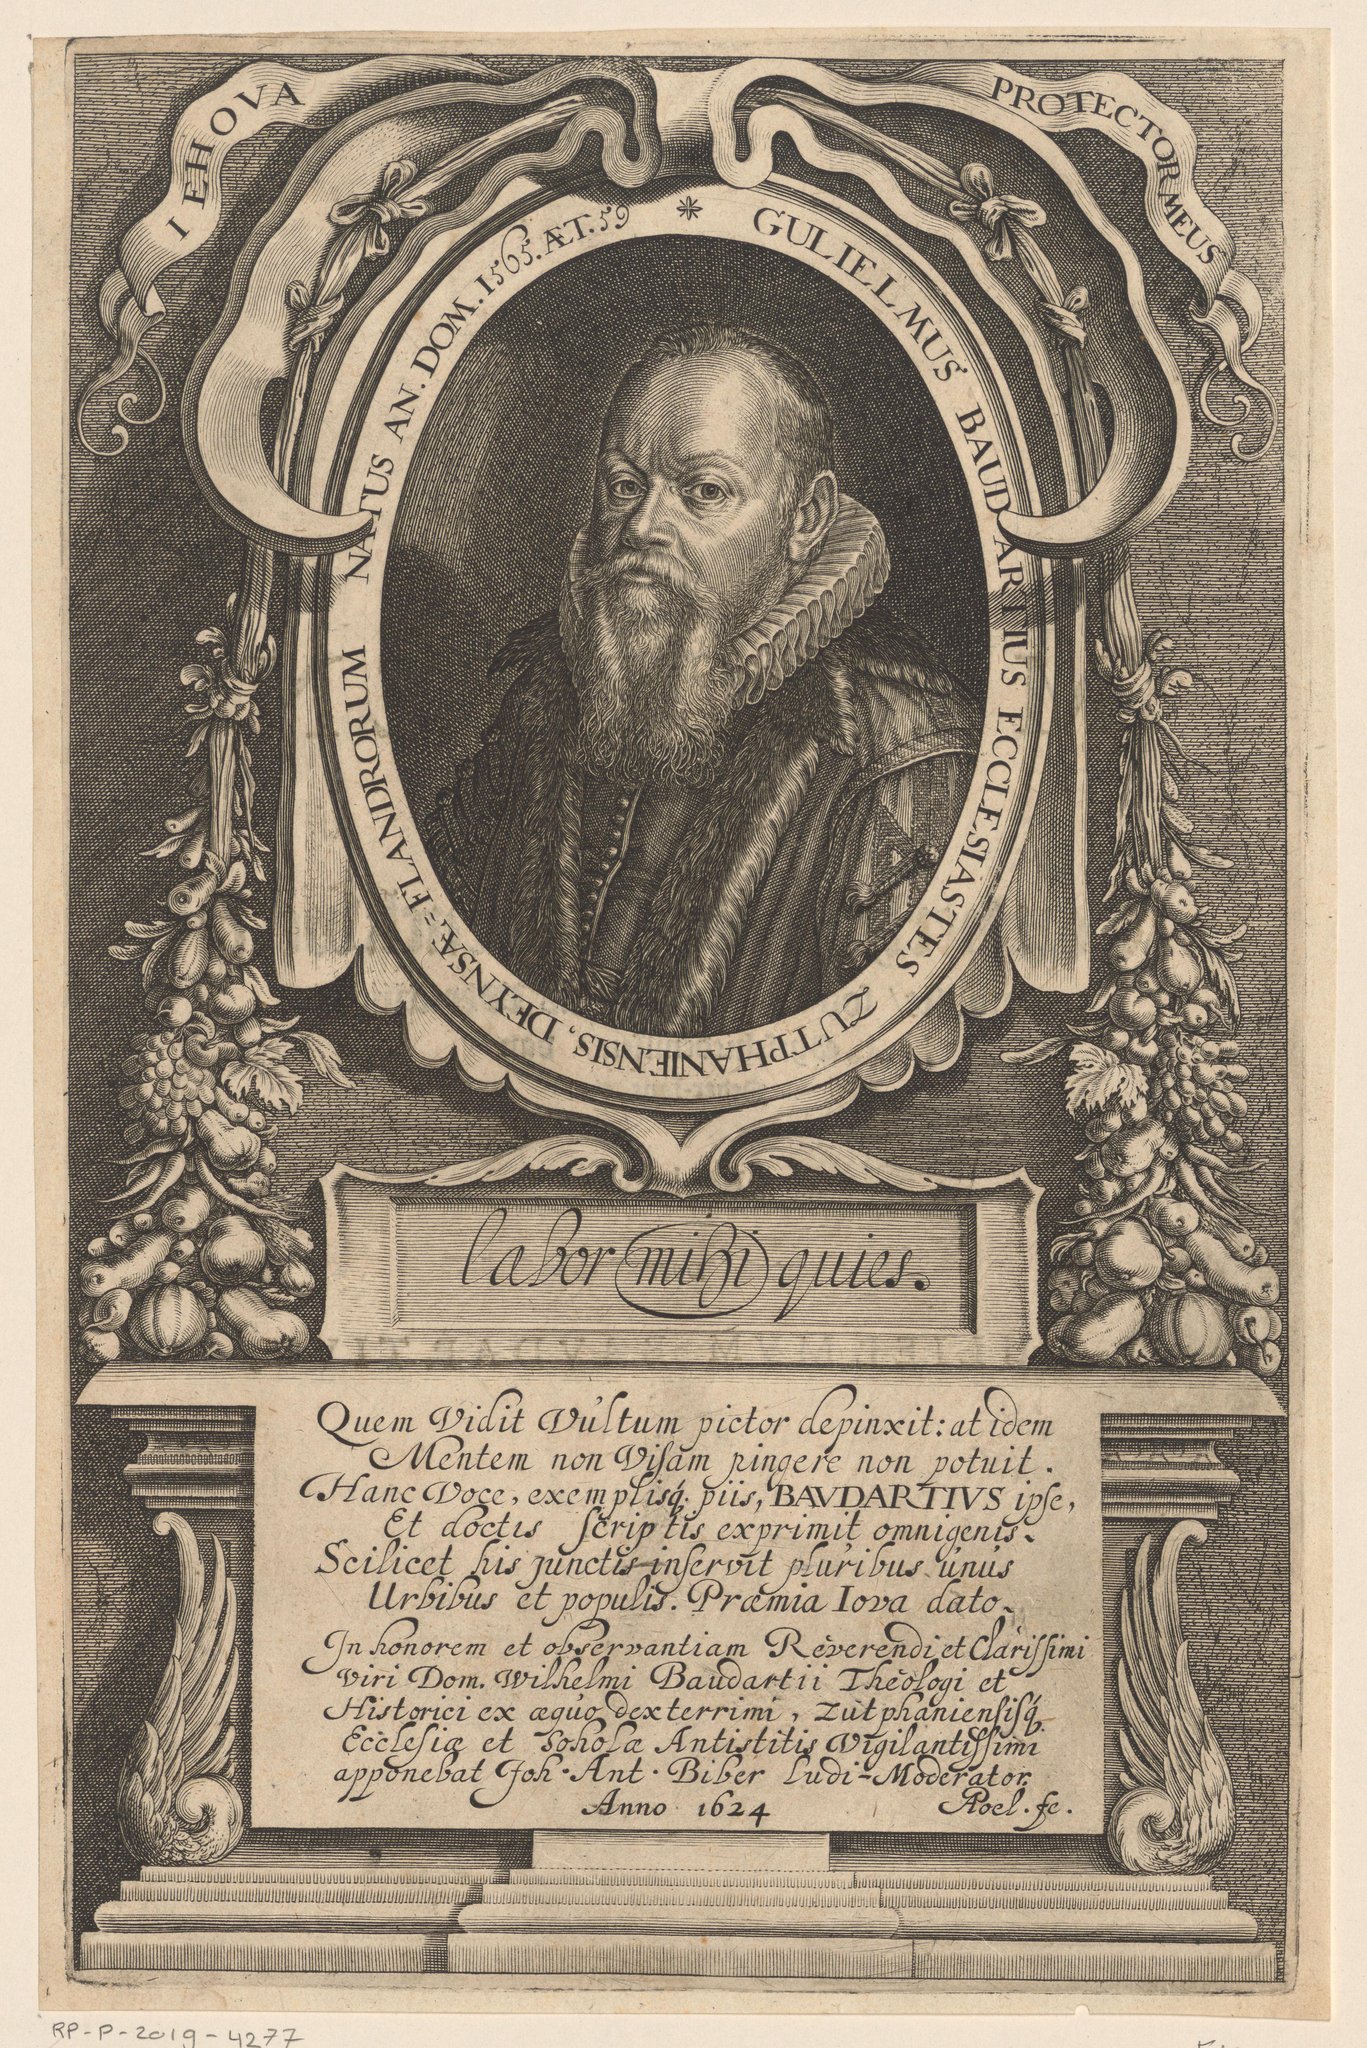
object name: print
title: Portret van Willem Baudartius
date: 1624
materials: paper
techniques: engraving, letterpress printing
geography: zutphen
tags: historical persons, fruits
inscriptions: date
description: Prent uit: Baudartius, Willem. Memoryen ofte cort verhael der gedenck-weerdichste so kercklicke als werltlicke gheschiedenissen (...). Zutphen: Andries Jansz. van Aelst, 1624. Prent ook gebruikt in latere edities van dit werk.